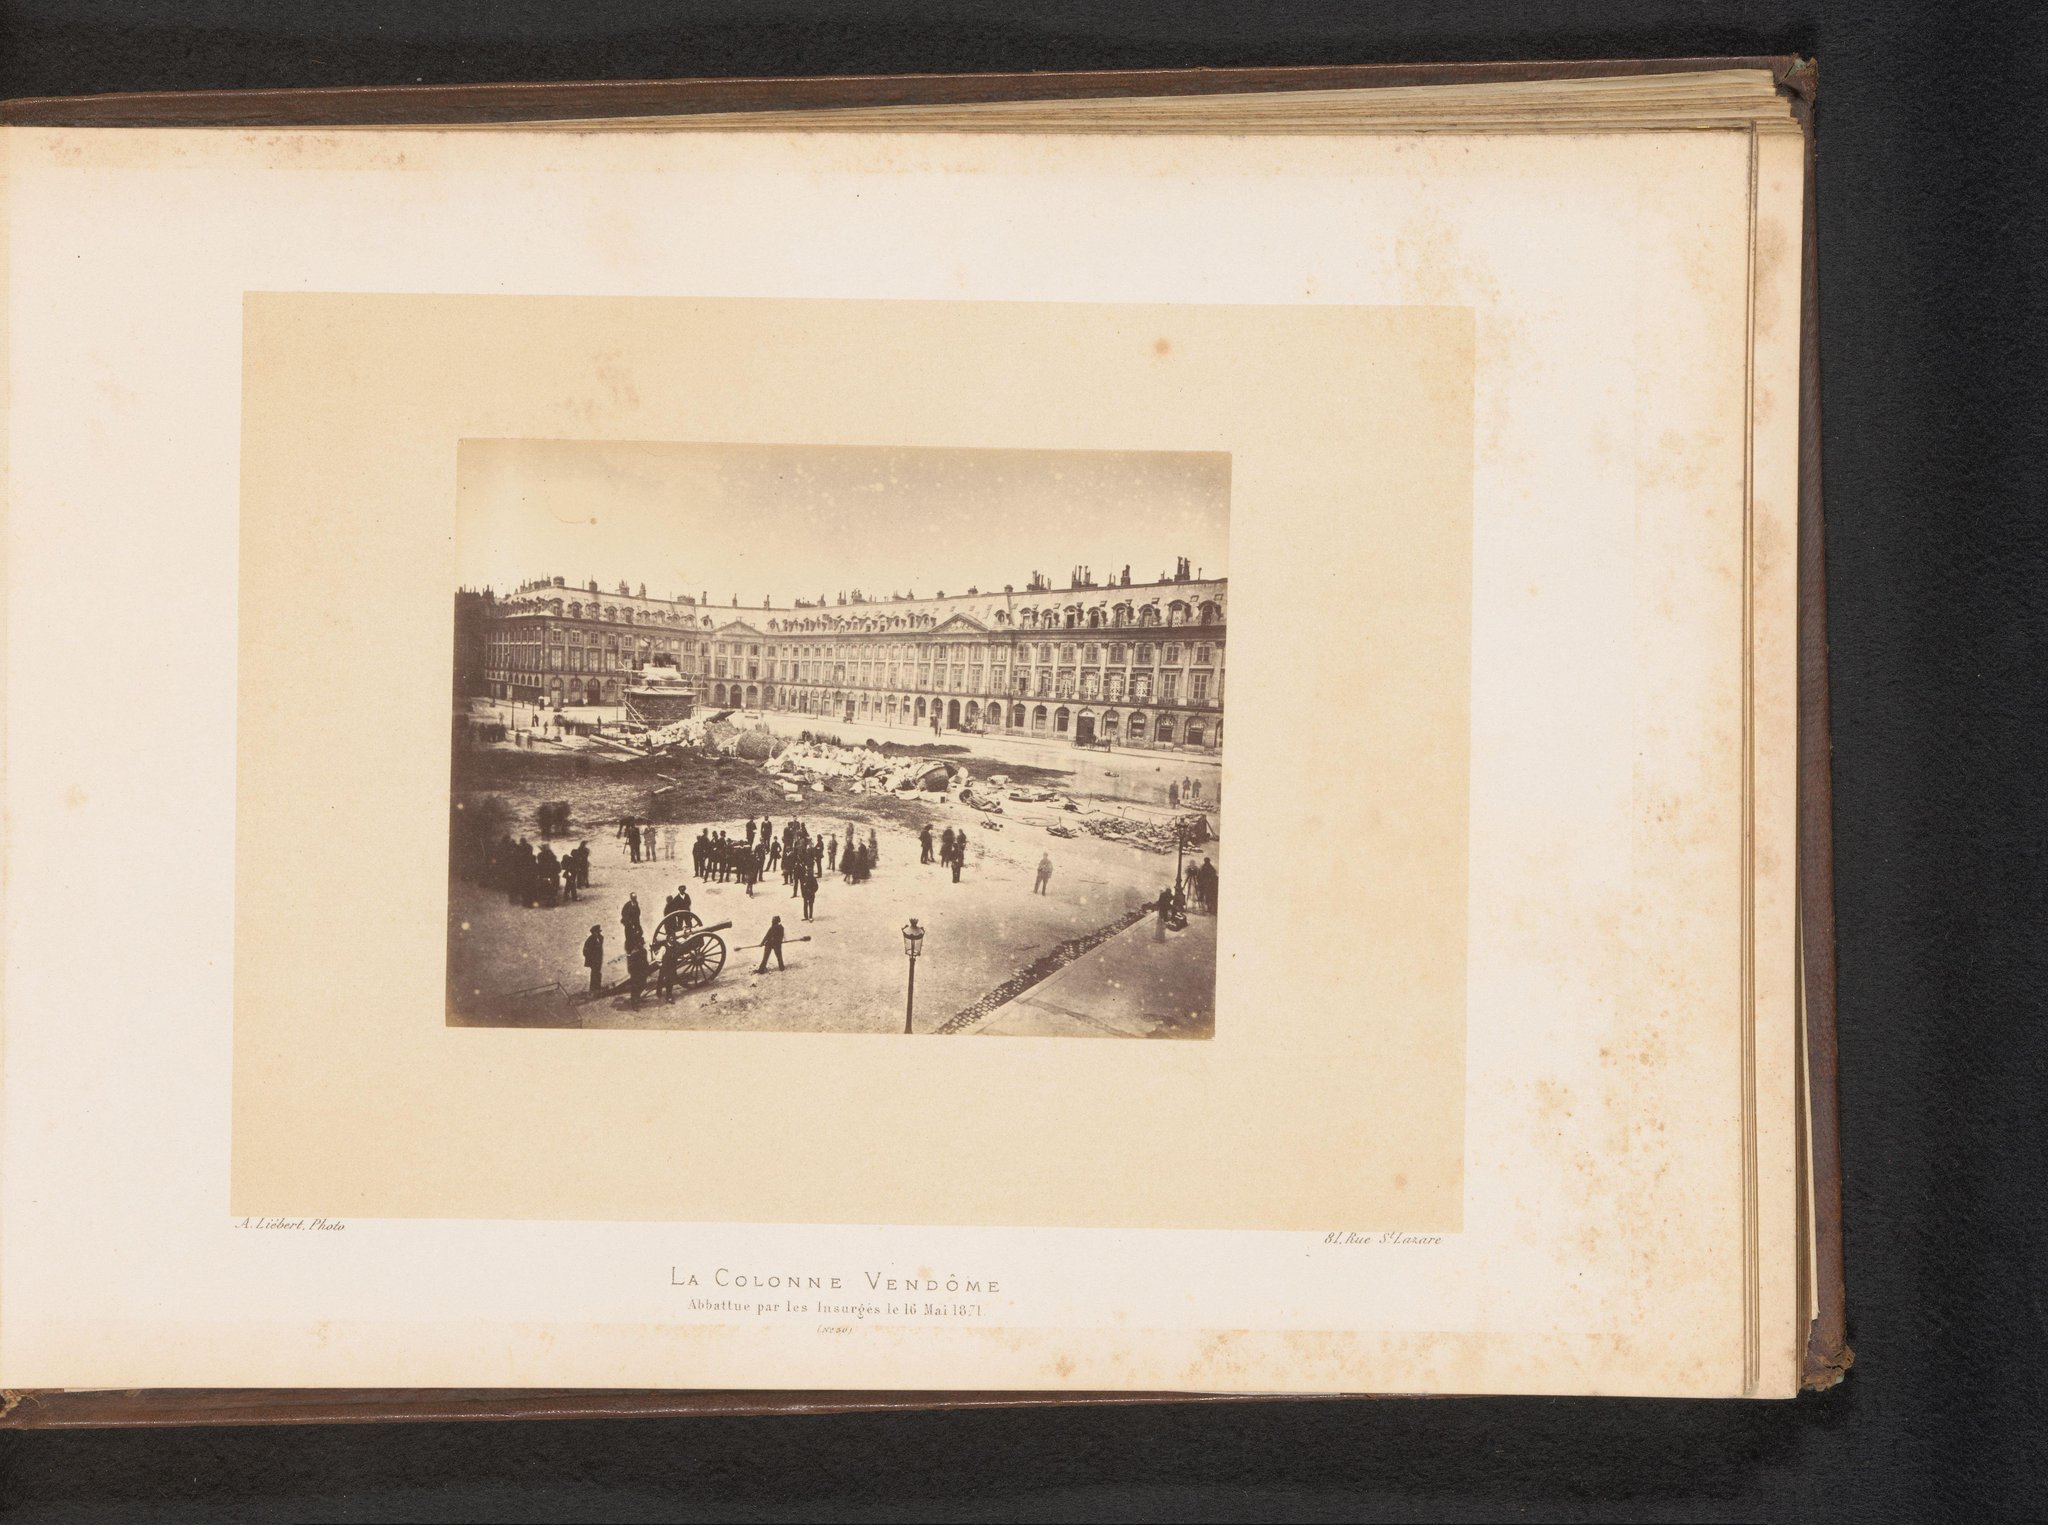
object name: page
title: Gezicht op het Place Vendôme in Parijs met de resten van de door de Commune van Parijs verwoeste Colonne Vendôme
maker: alphonse-justin liébert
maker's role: fotograaf, marinier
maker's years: 1827-1914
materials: photographic support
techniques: albumen print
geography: paris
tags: ruin of a building ~ architecture, triumphal column with helical friezes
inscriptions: address: ‘31, Rue St. Lazare’, number: ‘(No. 30)’